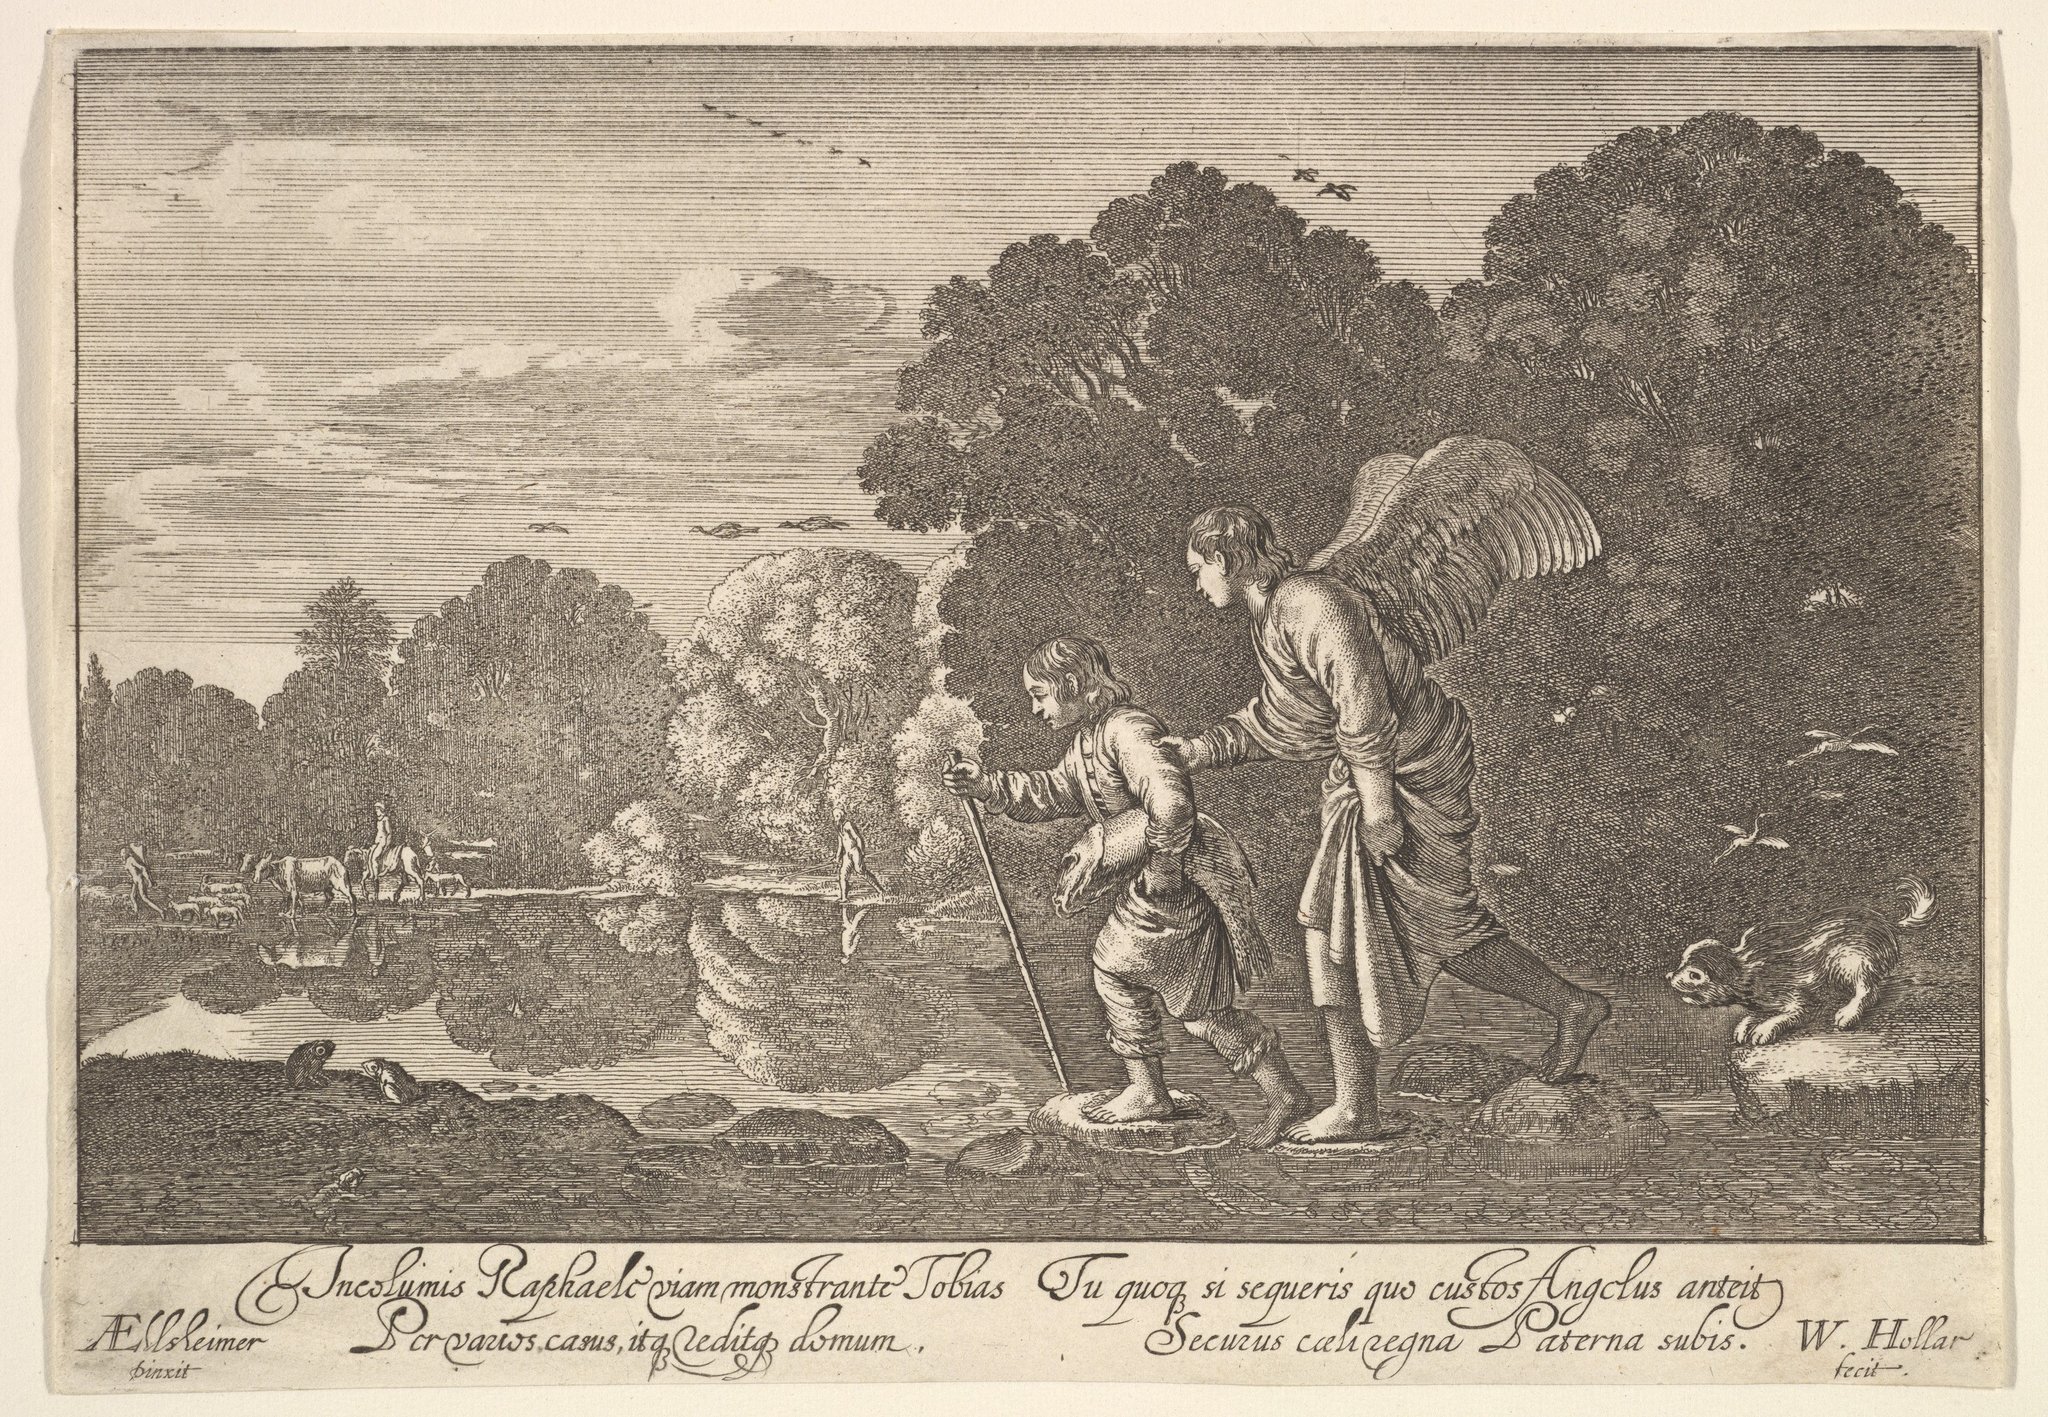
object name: print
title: Tobias and the Angel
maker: wenceslaus hollar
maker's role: artist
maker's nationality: bohemian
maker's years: 1607-1677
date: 1644-1652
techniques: etching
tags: boys,dogs,fish,landscapes,angels